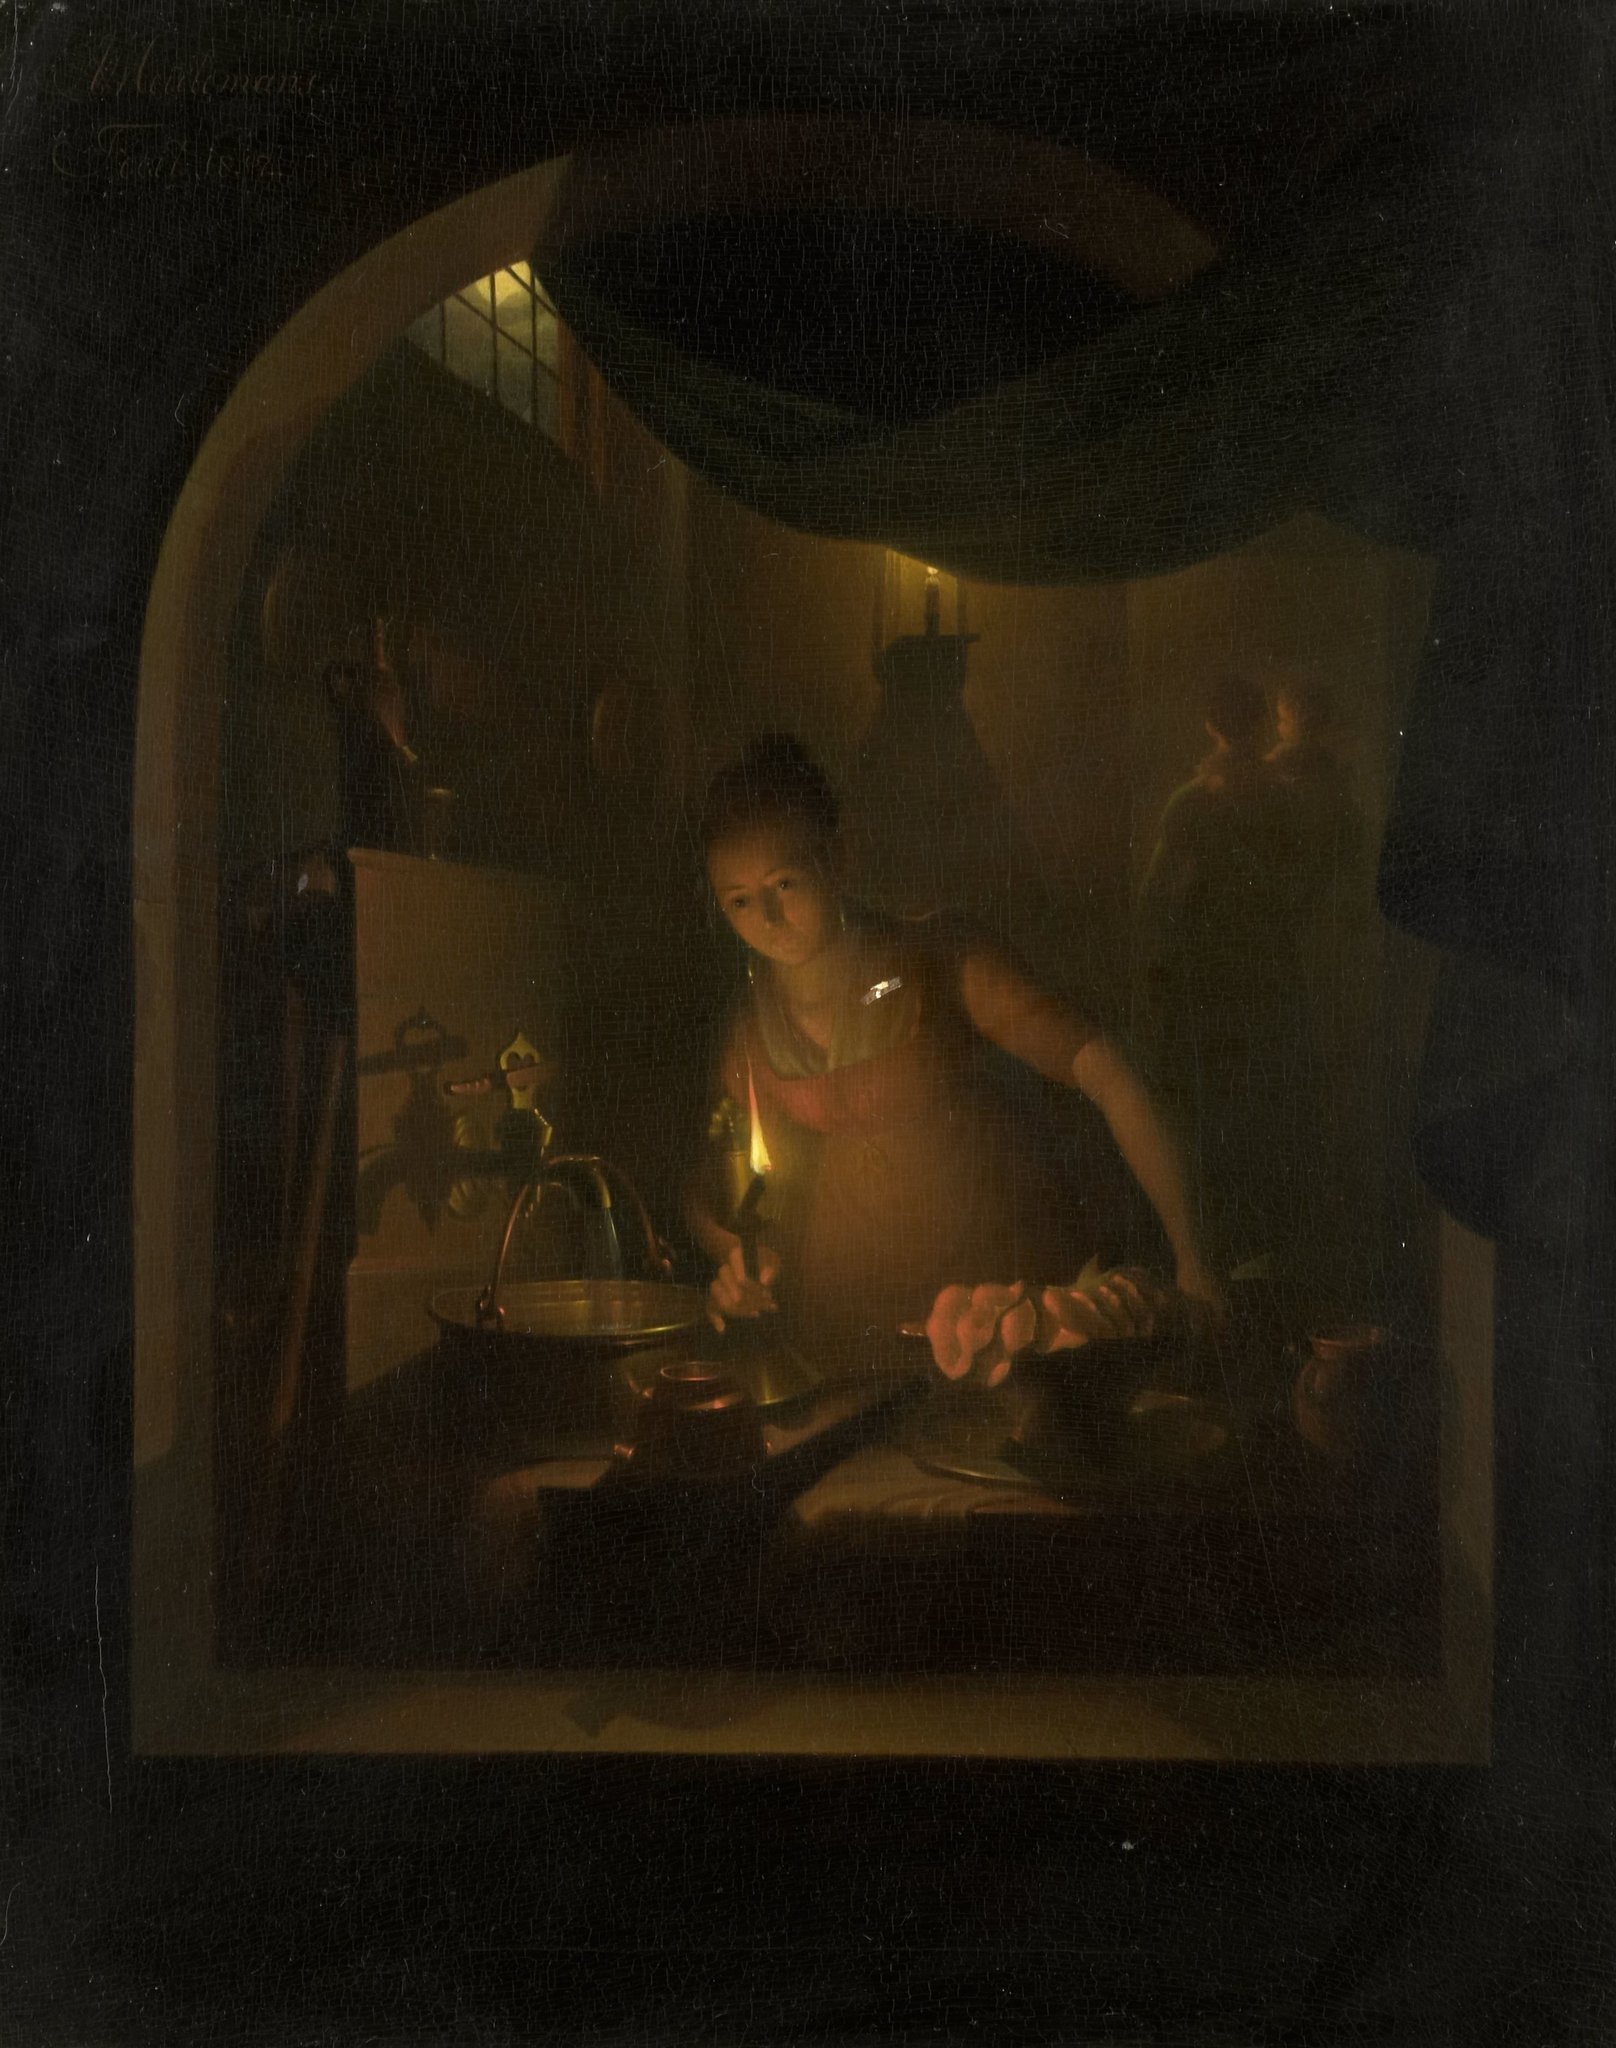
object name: painting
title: Kitchen by Lamplight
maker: adriaan meulemans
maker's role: painter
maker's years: 1763-1835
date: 1817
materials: oil, panel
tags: kitchen, oil-lamp, kitchen-maid, kitchen servant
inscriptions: signature and date: ‘A. Meulemans Fecit 1817’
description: Gezicht door een venster op een keuken bij lamplicht. Een keukenmeid vult een ketel met water uit een kraan, zij heeft een olielamp in de rechterhand. Op de achtergrond een staande vrouw met kind op de arm bij een kaars.